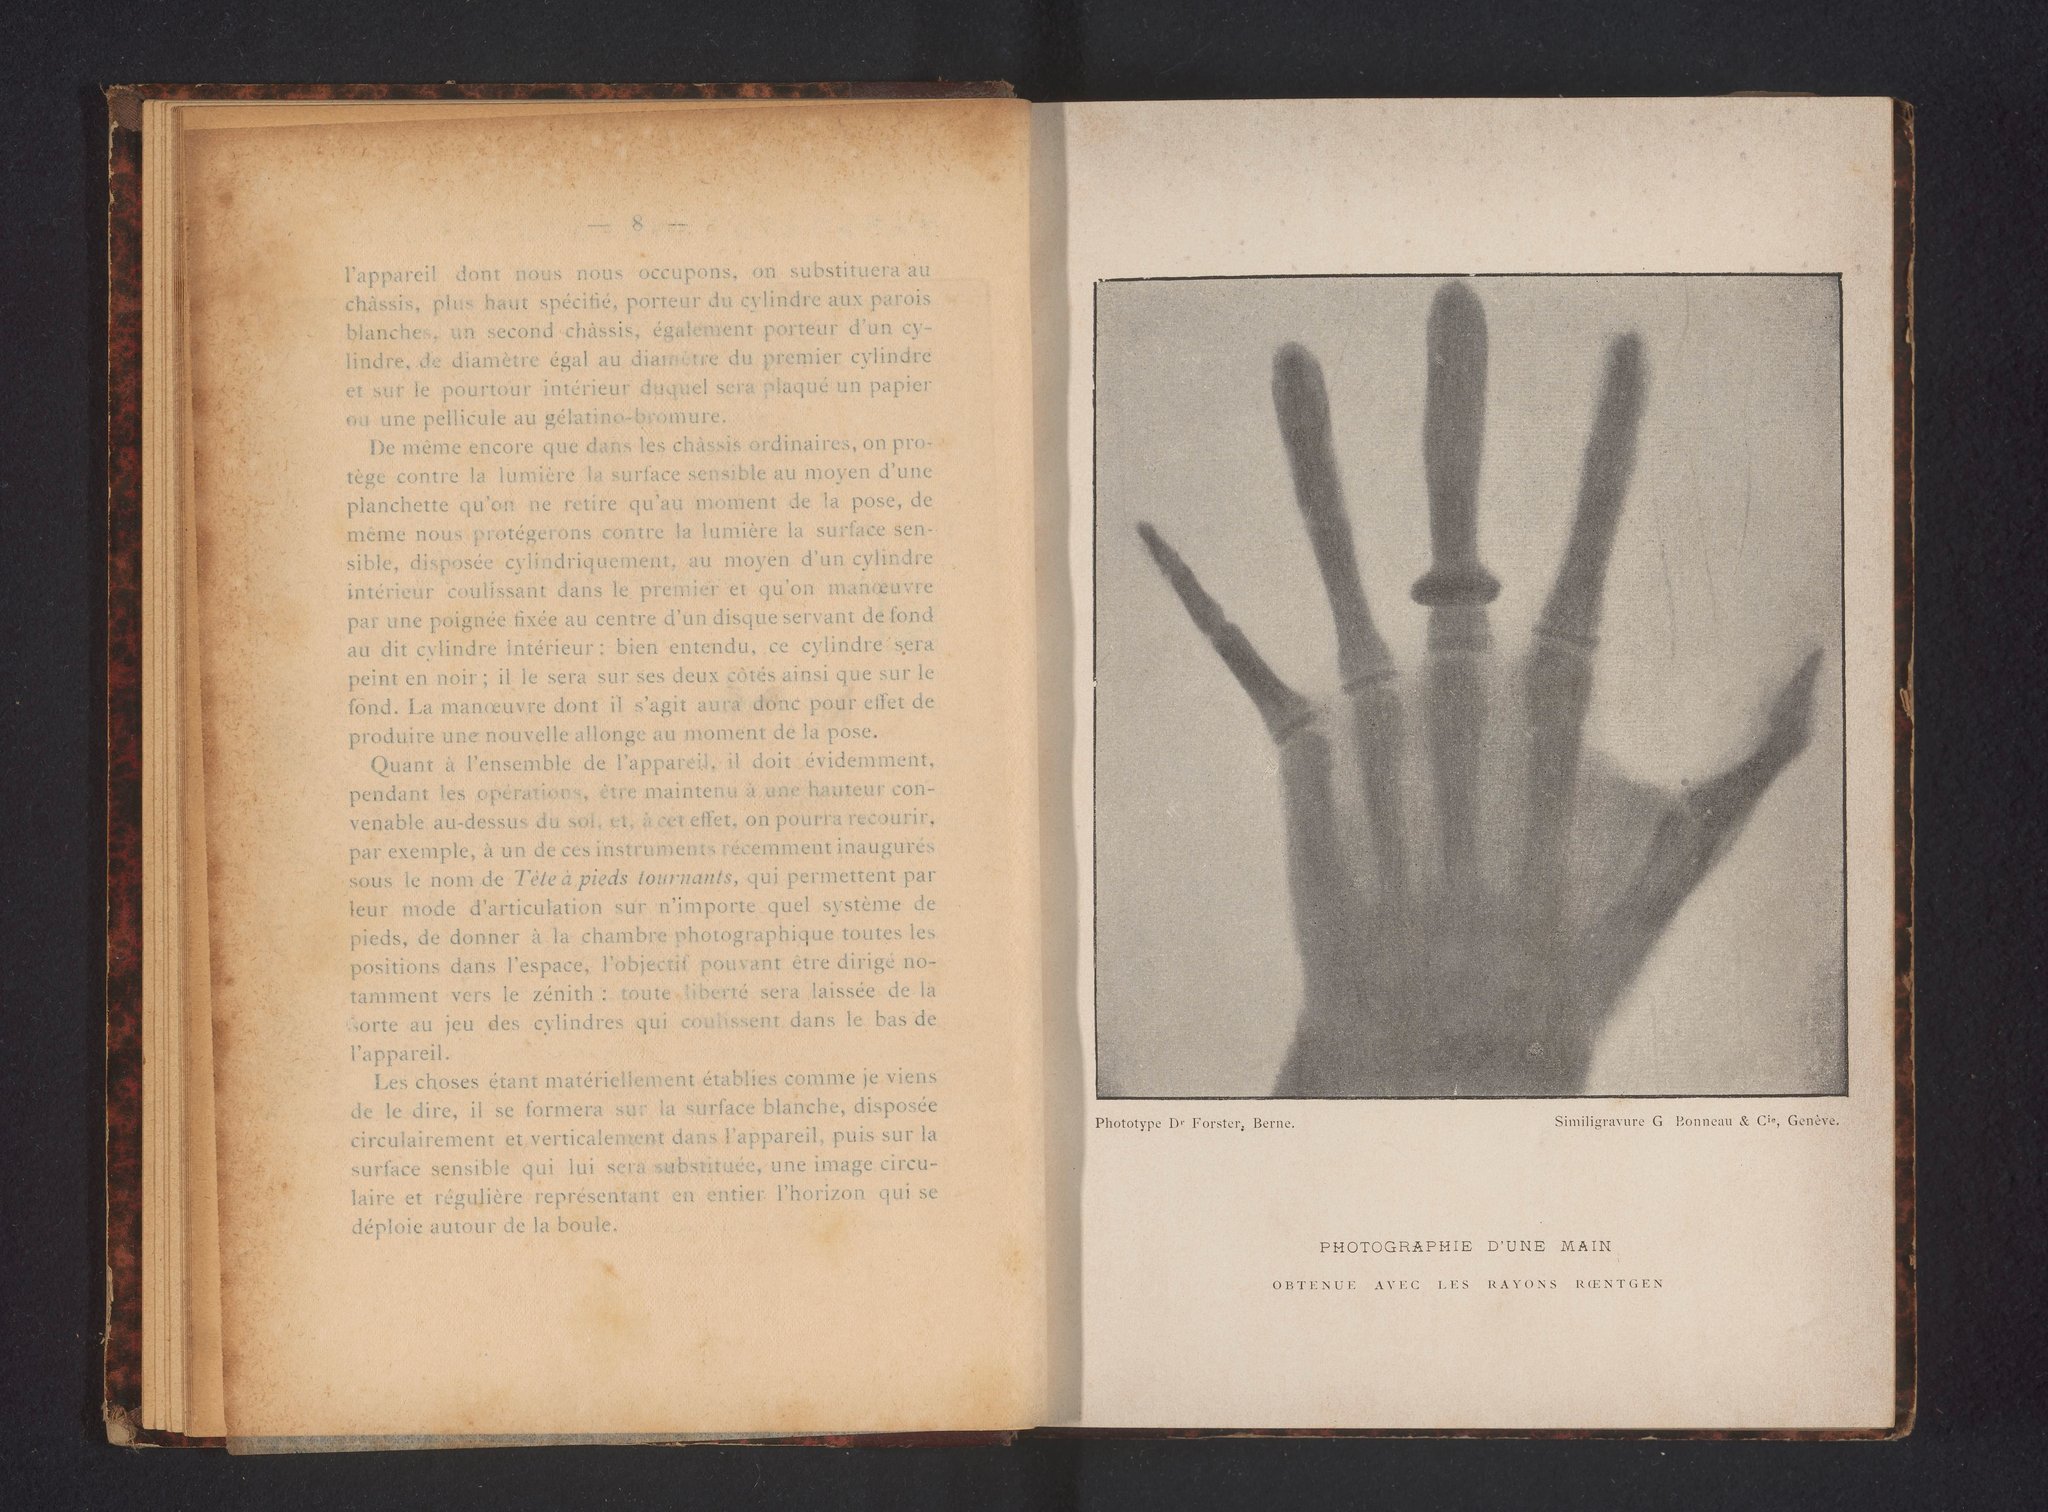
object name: page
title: Revue Suisse de photographie, 1896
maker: dr. foster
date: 1891-1896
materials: paper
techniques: autotype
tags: carpus and metacarpus, parts of the hand, x-ray examination